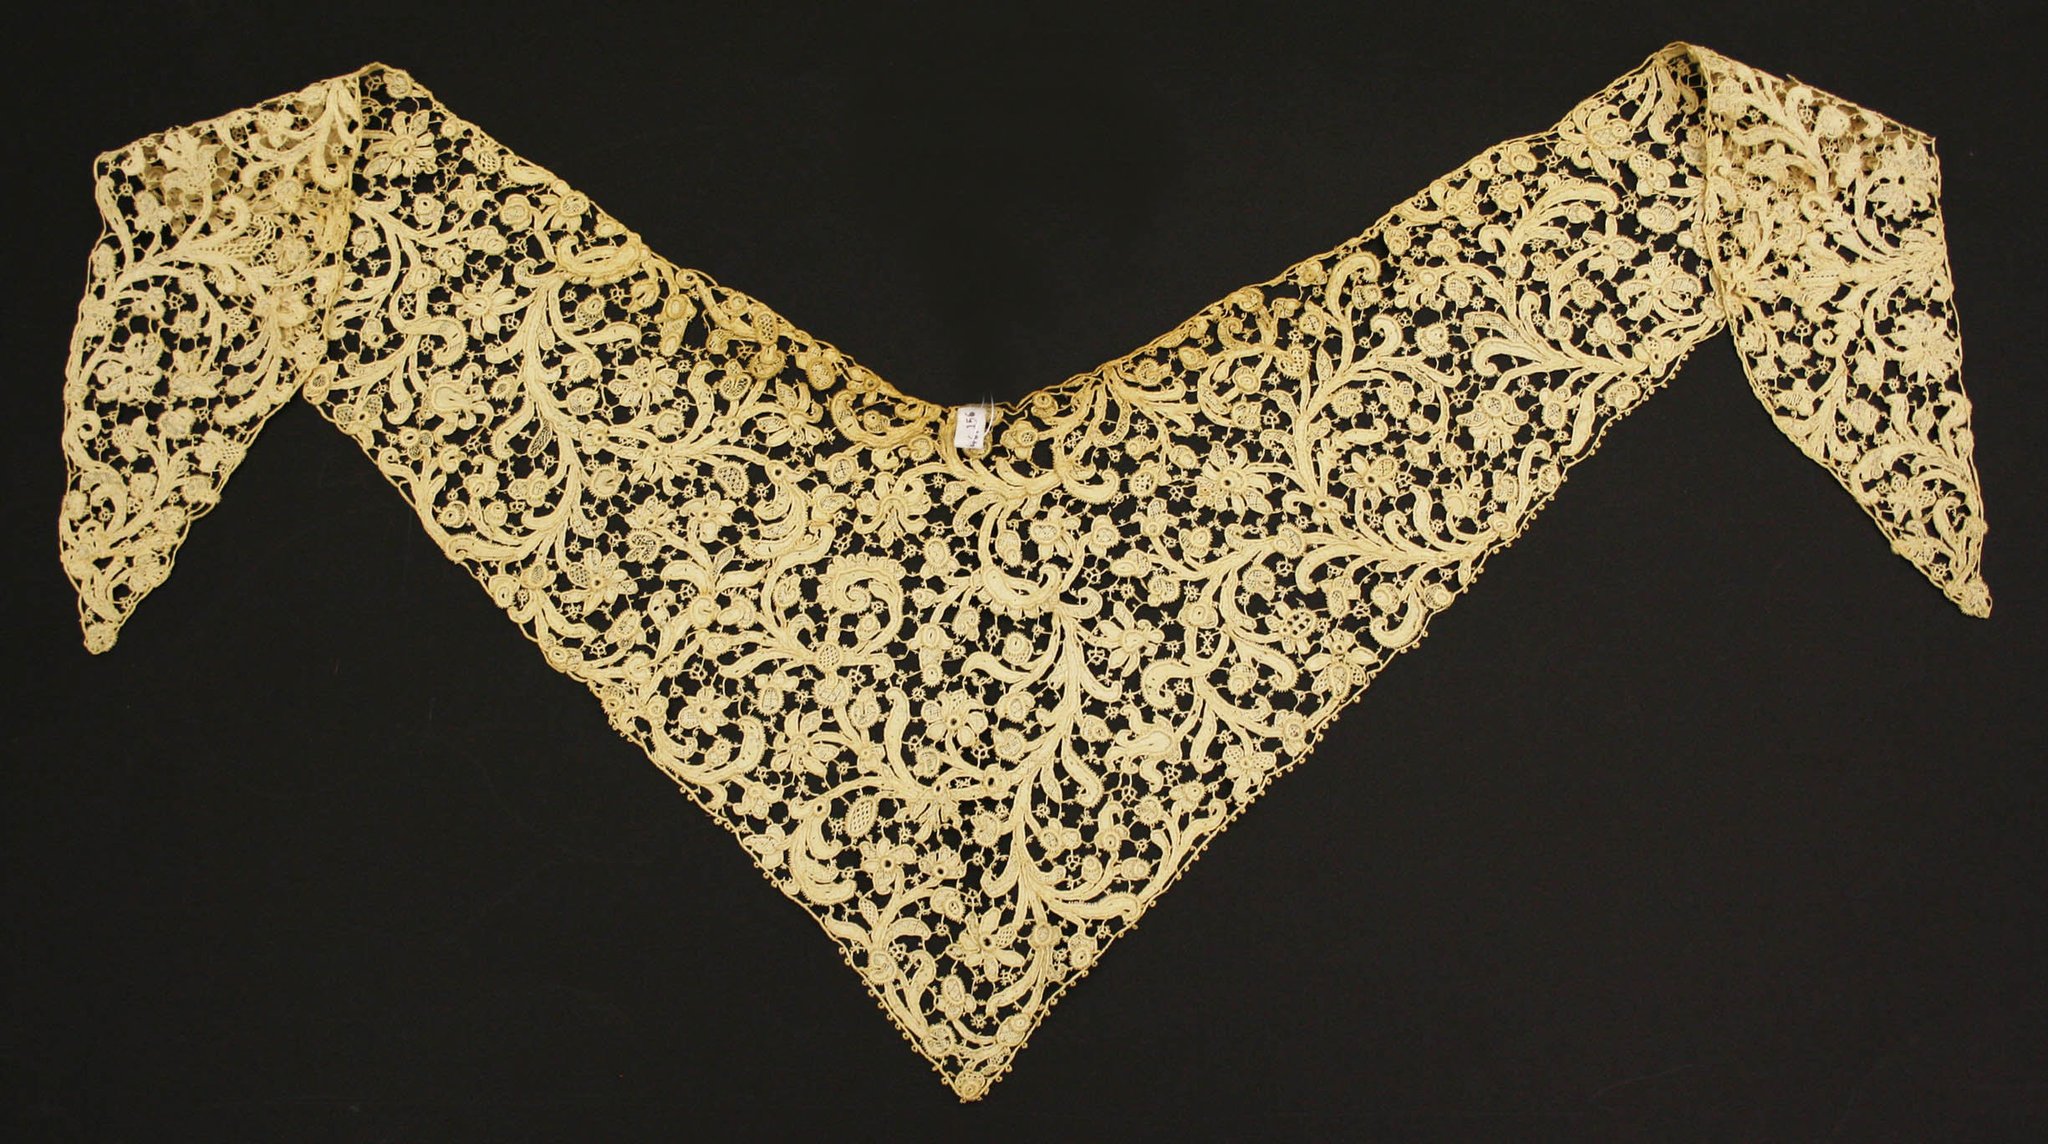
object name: collar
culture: italian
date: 1675-1725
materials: linen